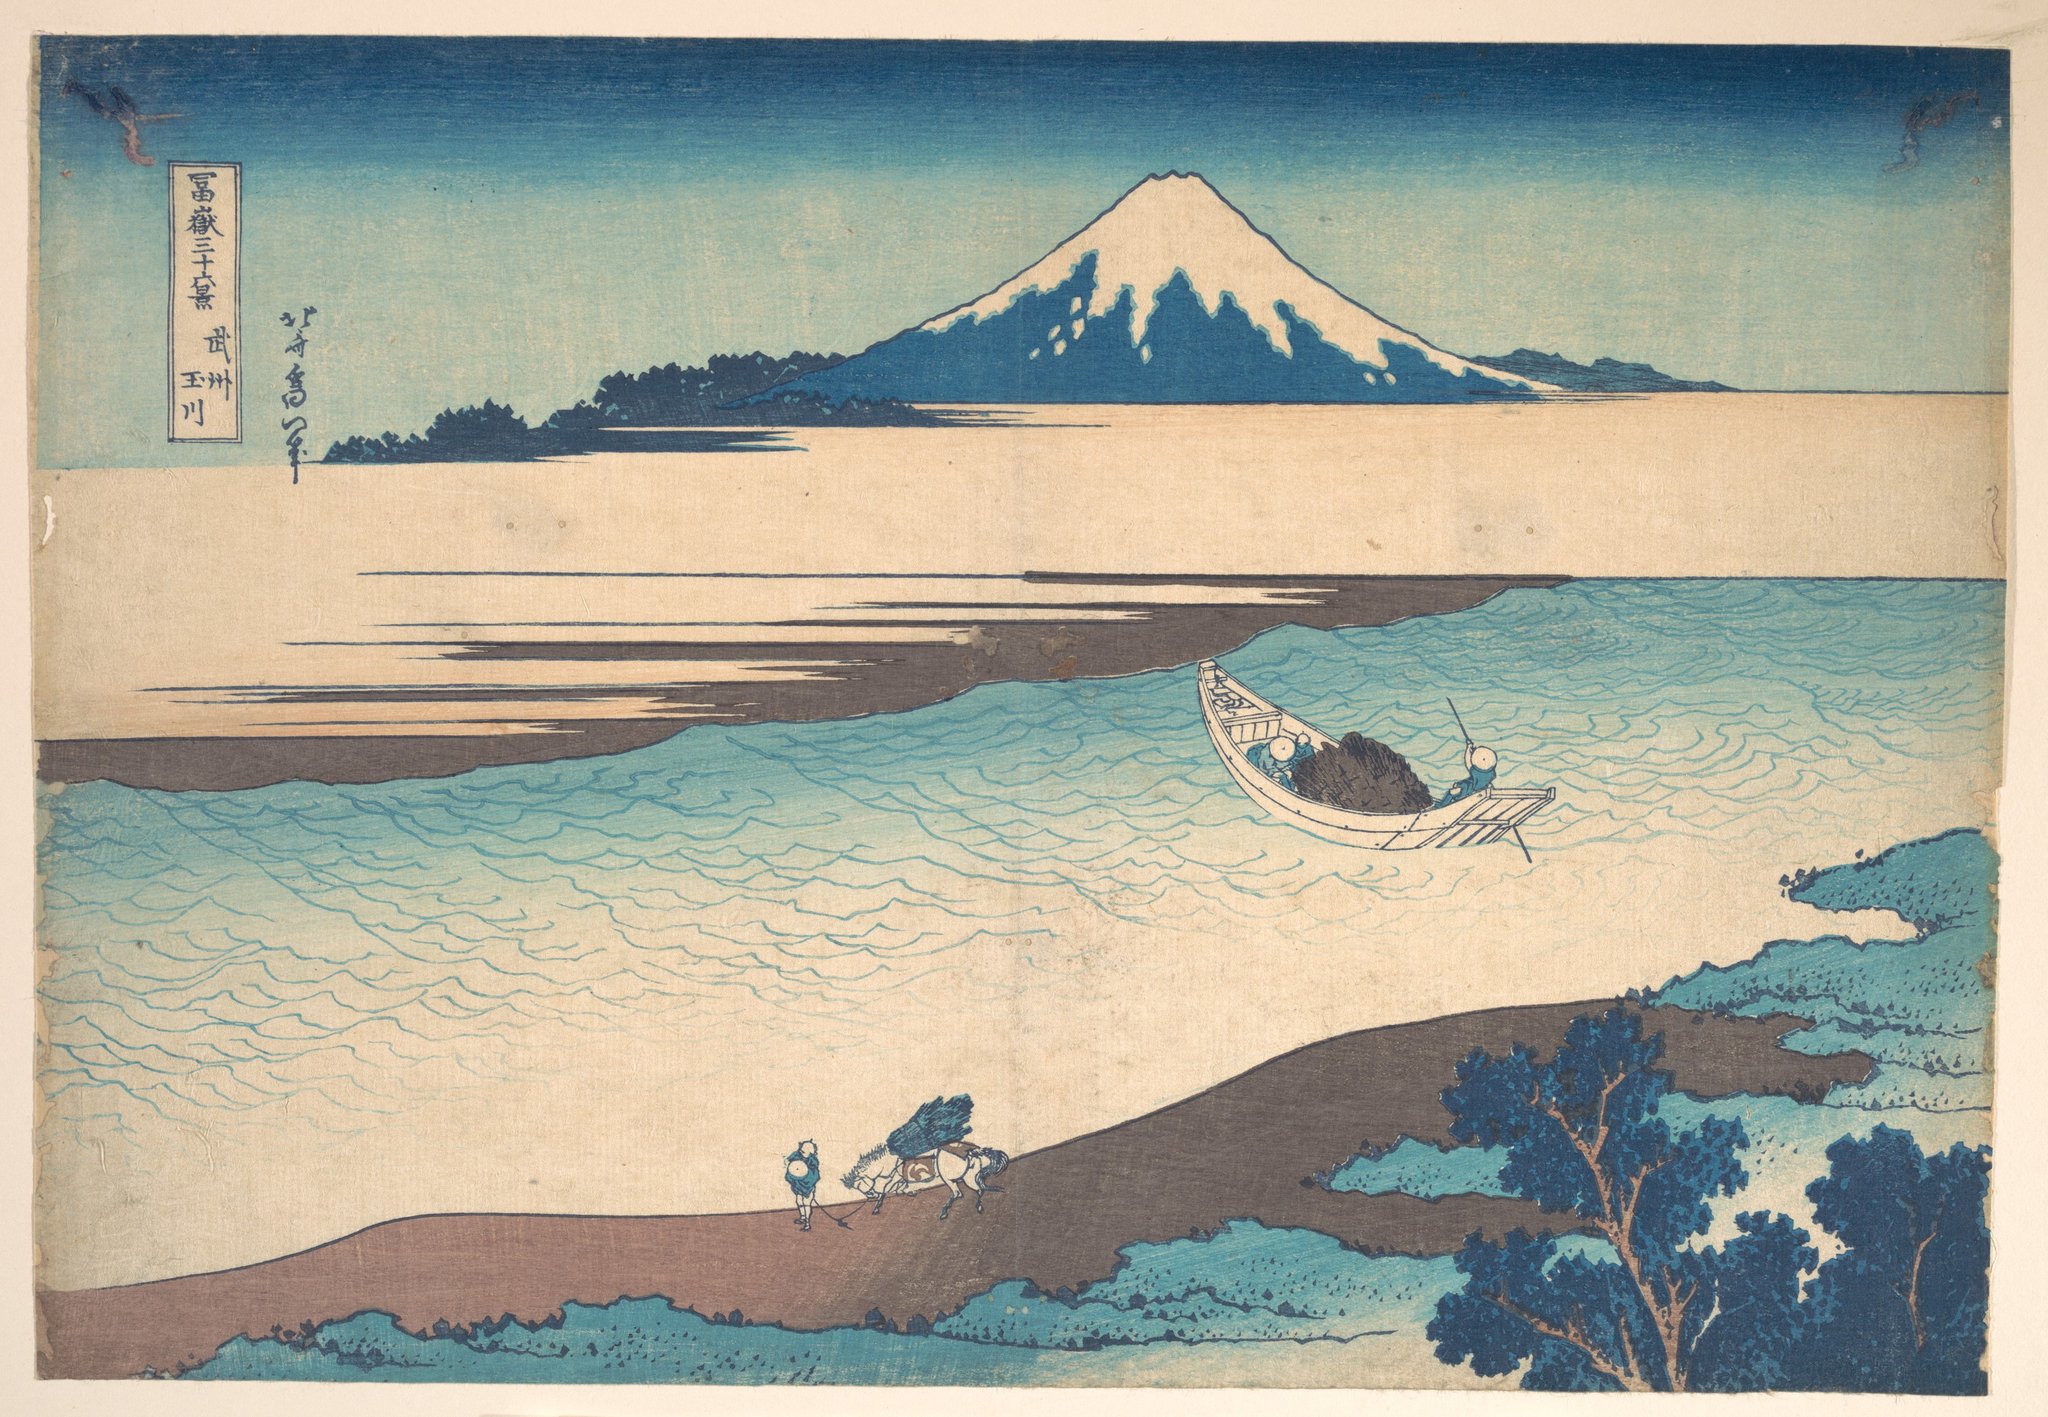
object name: print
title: Fuji—The Tama River, Musashi Province, from the series Thirty-six Views of Mount Fuji (Fugaku sanjūrokkei)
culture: japanese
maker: katsushika hokusai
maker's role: artist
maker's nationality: japanese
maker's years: 1760-1849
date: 1830-1832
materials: ink, paper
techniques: woodblock print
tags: horses,rivers,mountains,trees,boats